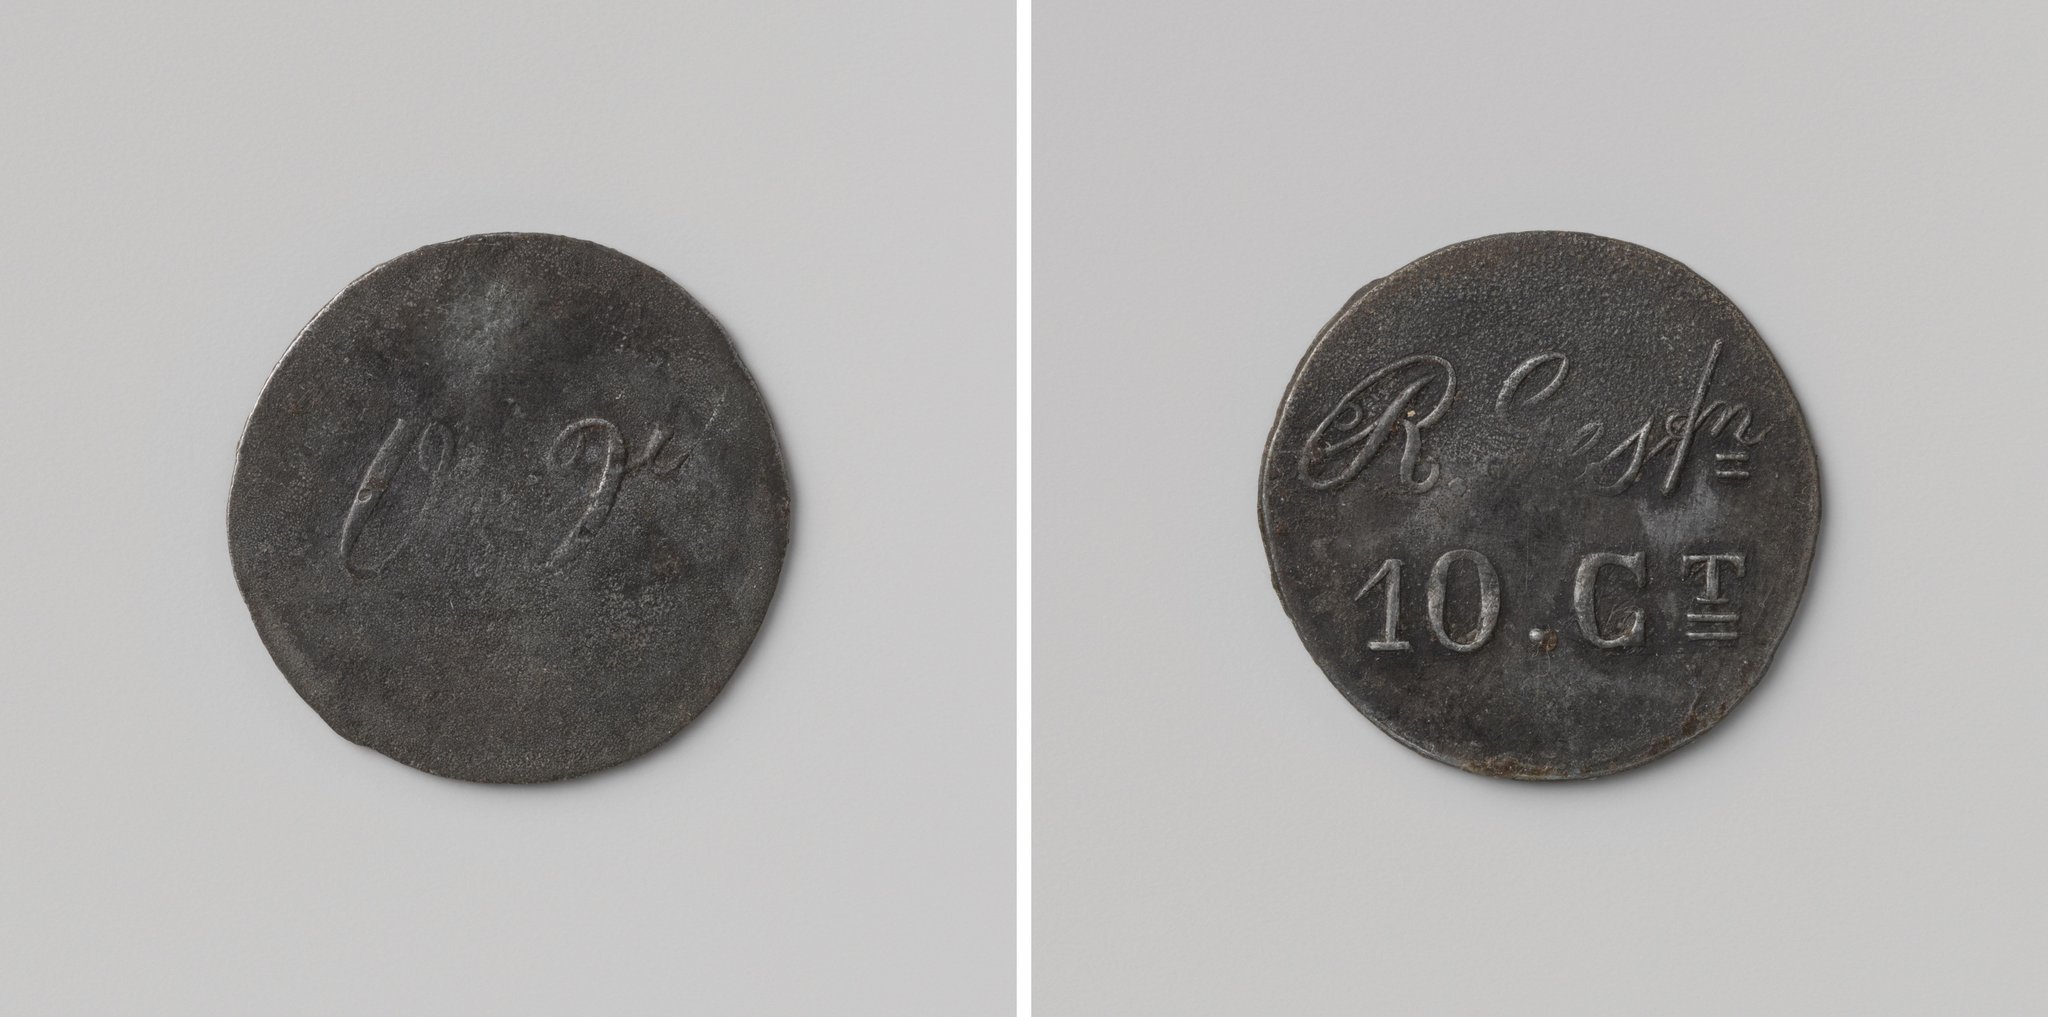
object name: huismunt prison money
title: Rijksgestichten Ommerschans en Veenhuizen, huismunt geslagen op last van de Maatschappij van Weldadigheid ter waarde van tien cent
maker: Anonymous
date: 1848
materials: zinc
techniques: striking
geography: netherlands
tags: maatschappij van weldadigheid, veenhuizen, ommerschans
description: Zinken munt. Voorzijde: letters O en V. Keerzijde: opschrift boven waardeaanduiding